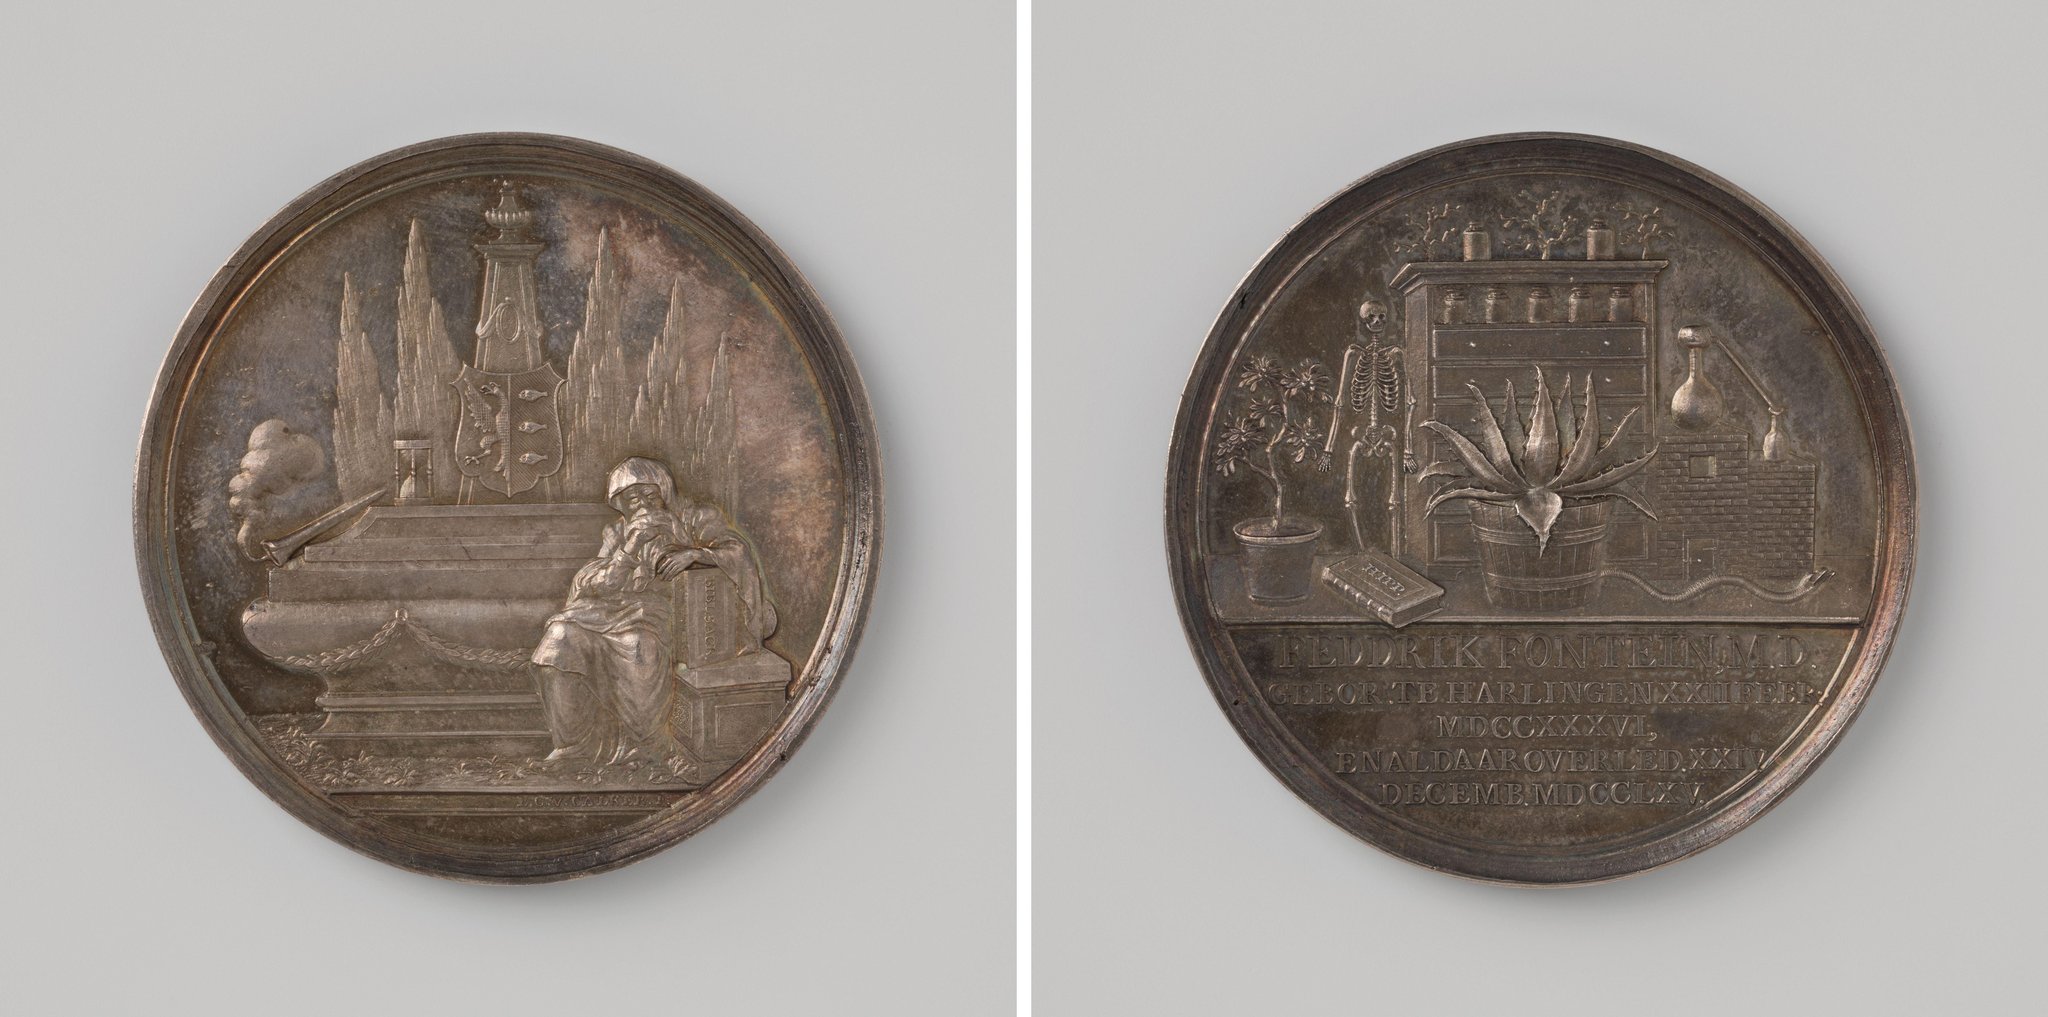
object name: history medal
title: Overlijden van Feddrik Fontein, geneesheer te Harlingen 1765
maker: barend christiaan van calker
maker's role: medailleur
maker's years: 1739-1813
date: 1765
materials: silver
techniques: striking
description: Zilveren penning, op de voorzijde een grafmonument met familiewapen waarnaast een treurende gesluierede vrouw, leunend op een bijbel op een altaar, op de keerzijde medische attributen als potten met kruiden, een boek HIPP., een skelet, een kast met medicijnflessen en een destilleerapparaat, met afsnedetekst.